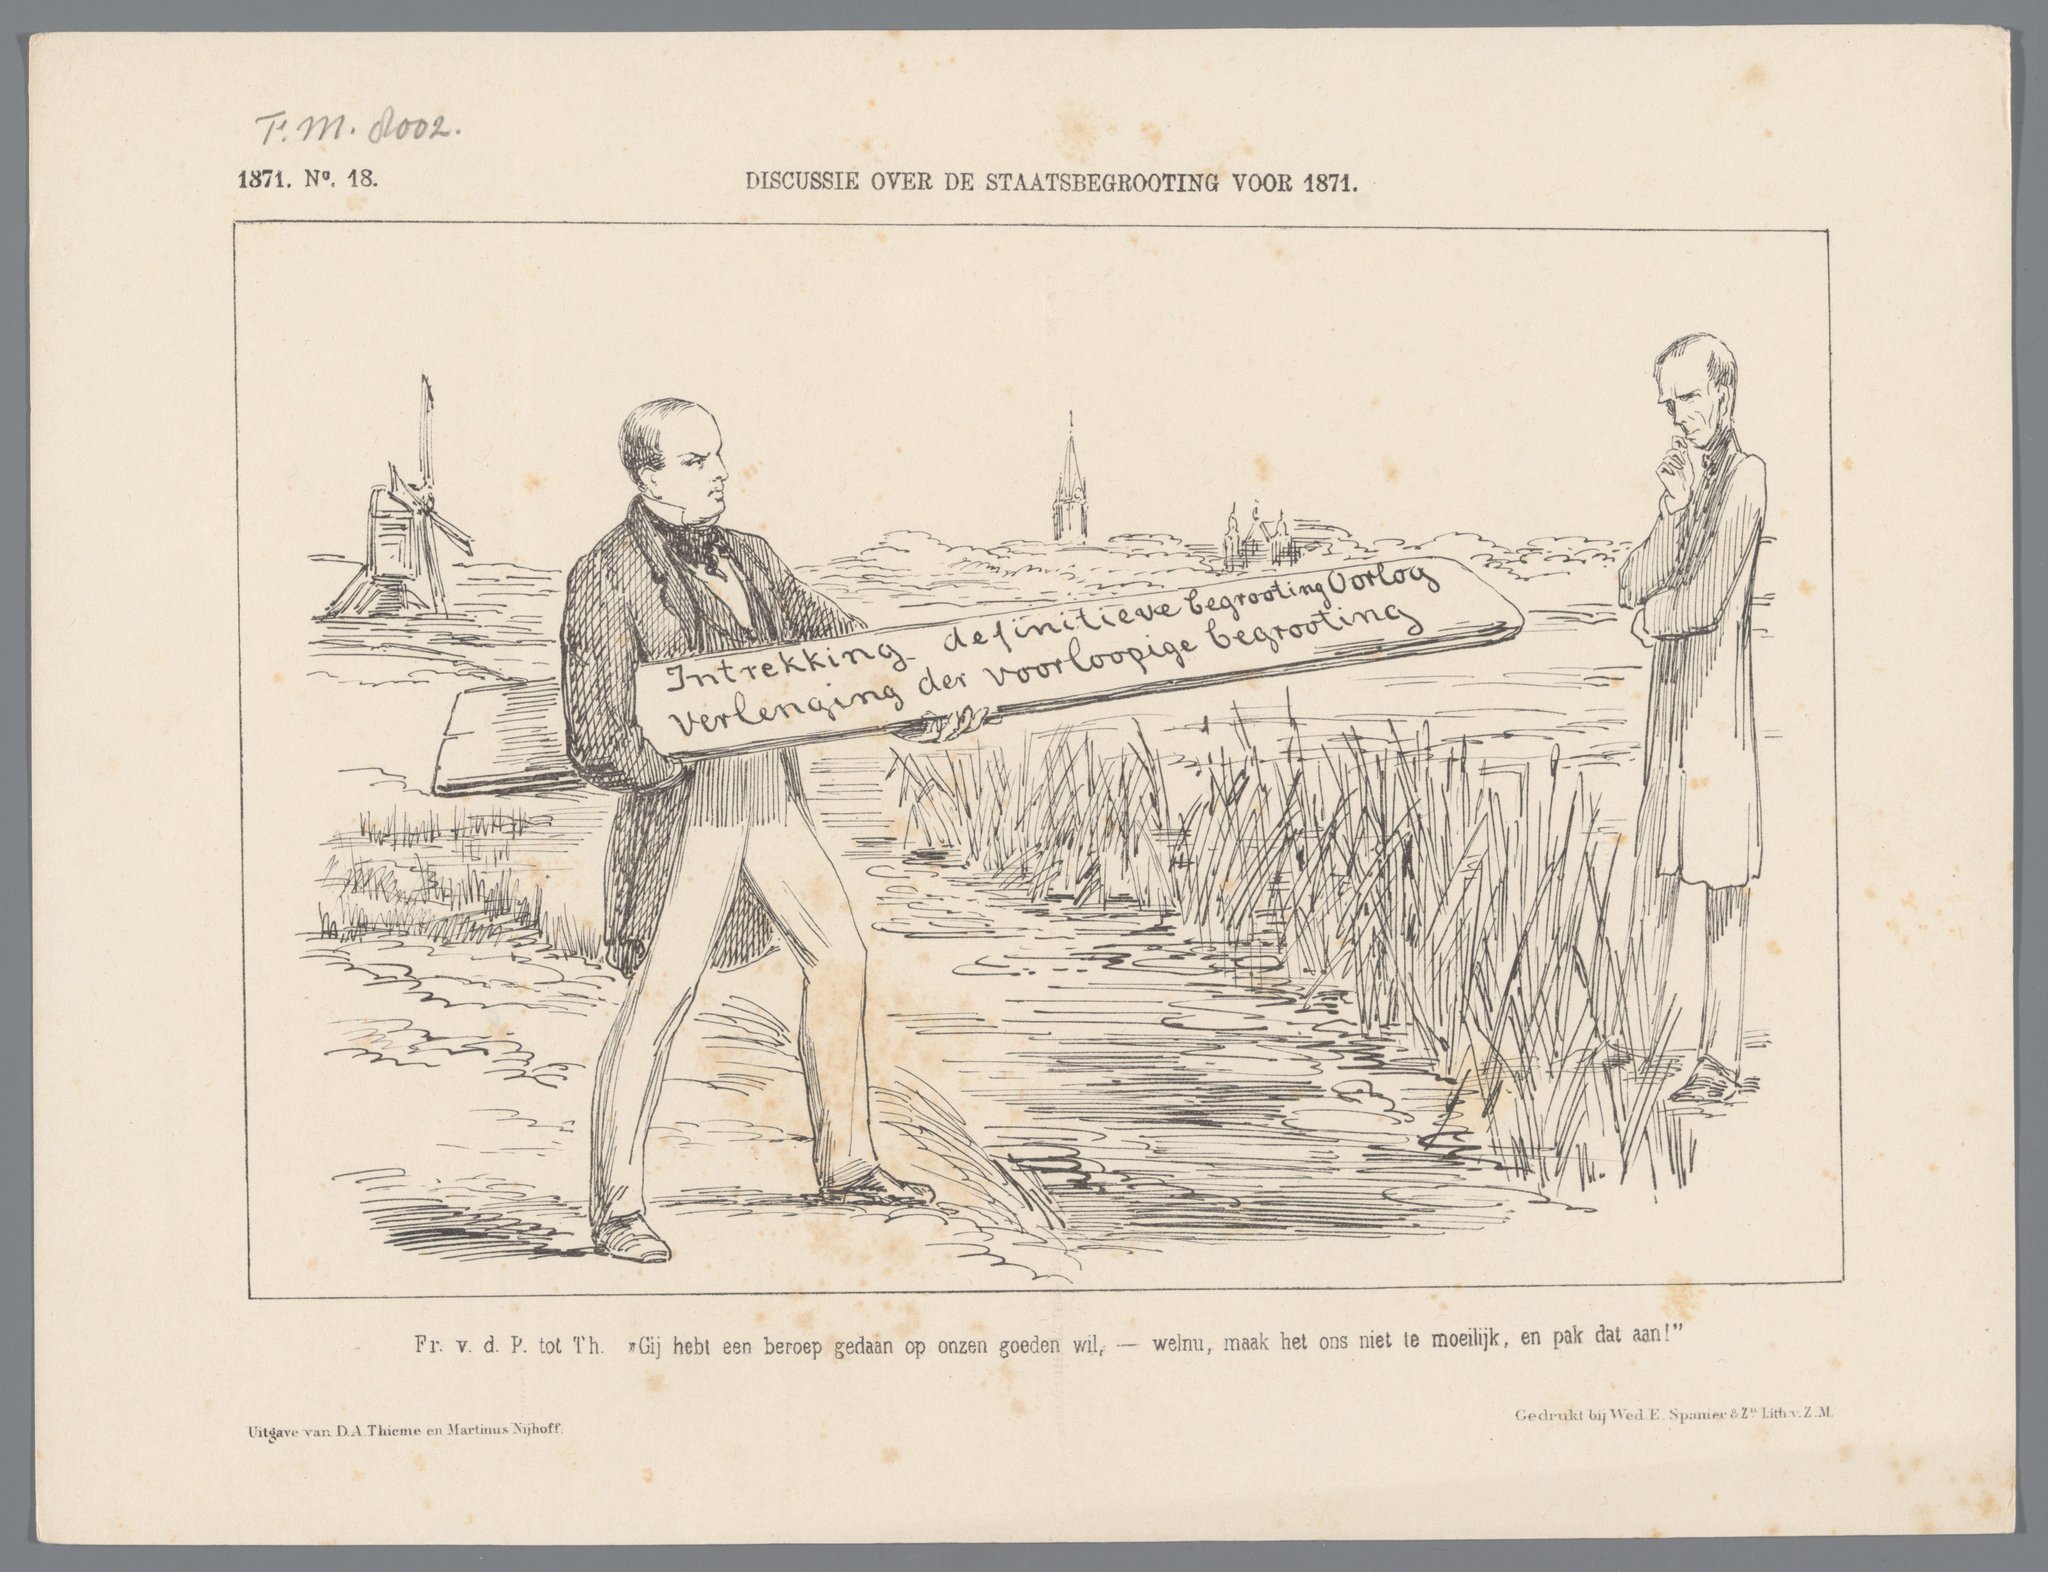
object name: print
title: Spotprent over de begroting van het Ministerie van Oorlog, 1871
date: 1871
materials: paper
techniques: lithograph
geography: arnhem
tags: johan rudolf thorbecke, politician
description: Spotprent op de beraadslagingen over de begroting van het Ministerie van Oorlog door Thorbecke en Fransen van de Putte. Plaat verschenen bij het weekblad De Nederlandsche Spectator, nr. 18, 1871.